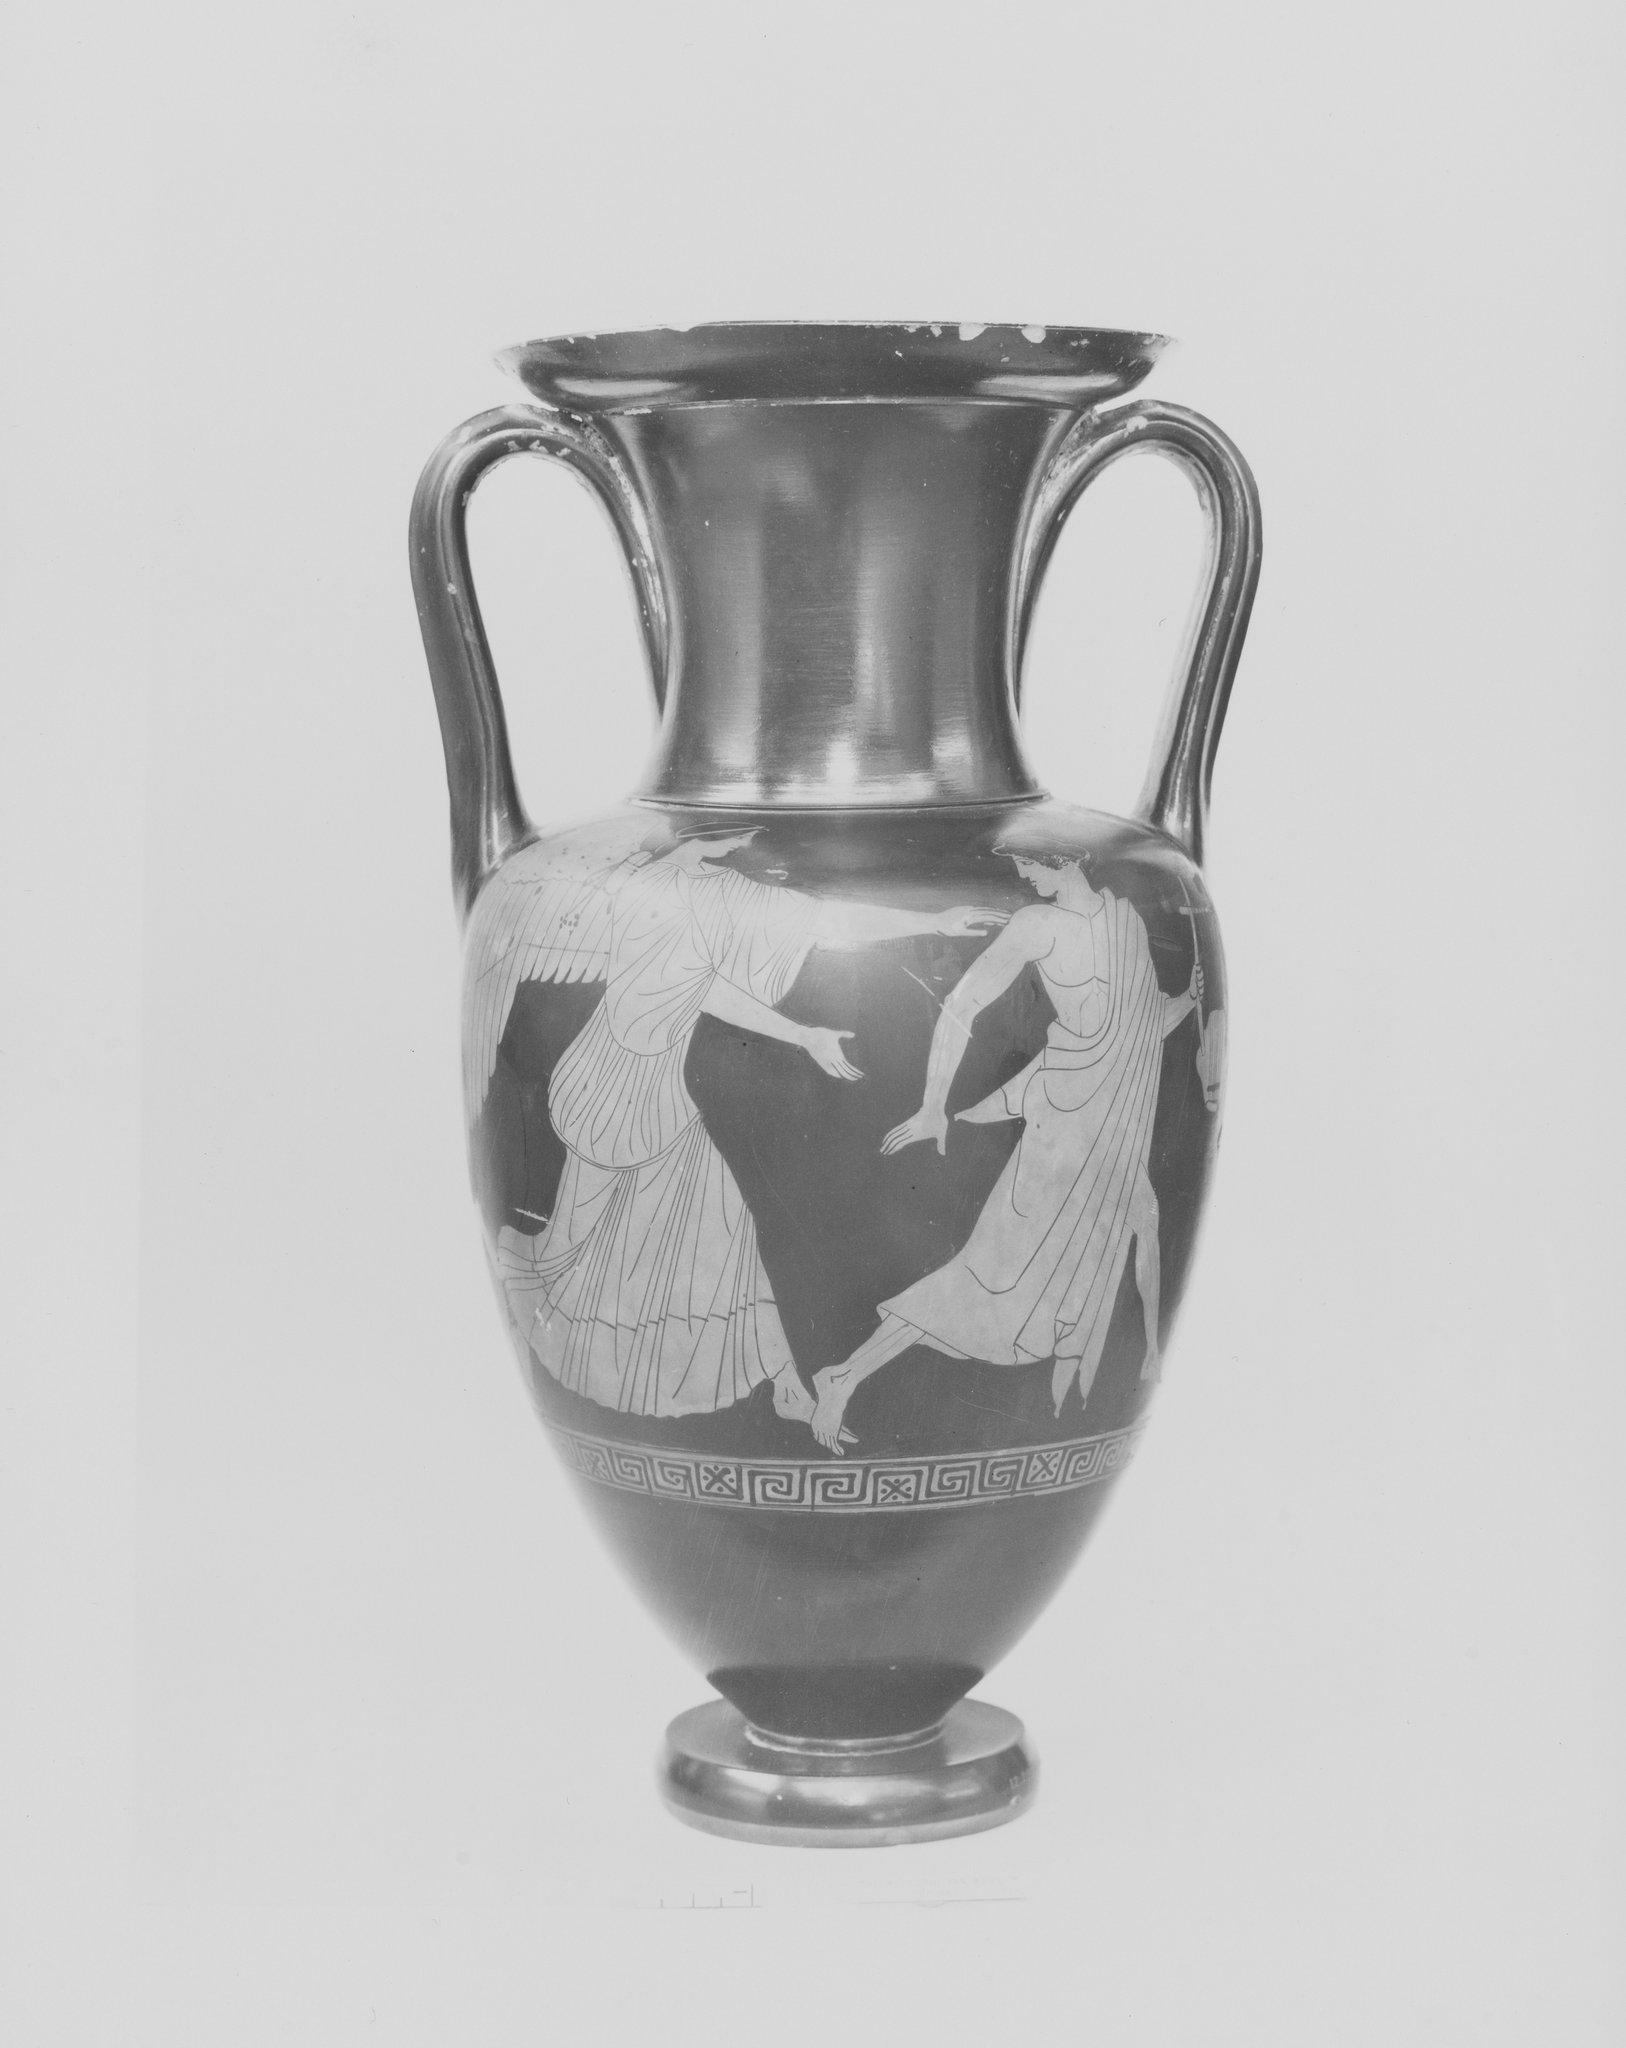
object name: nolan neck amphora with ridged handle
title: Terracotta Nolan neck-amphora (jar)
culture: greek, attic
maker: achilles painter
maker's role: artist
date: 460-450 BCE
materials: terracotta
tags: boys,goddess